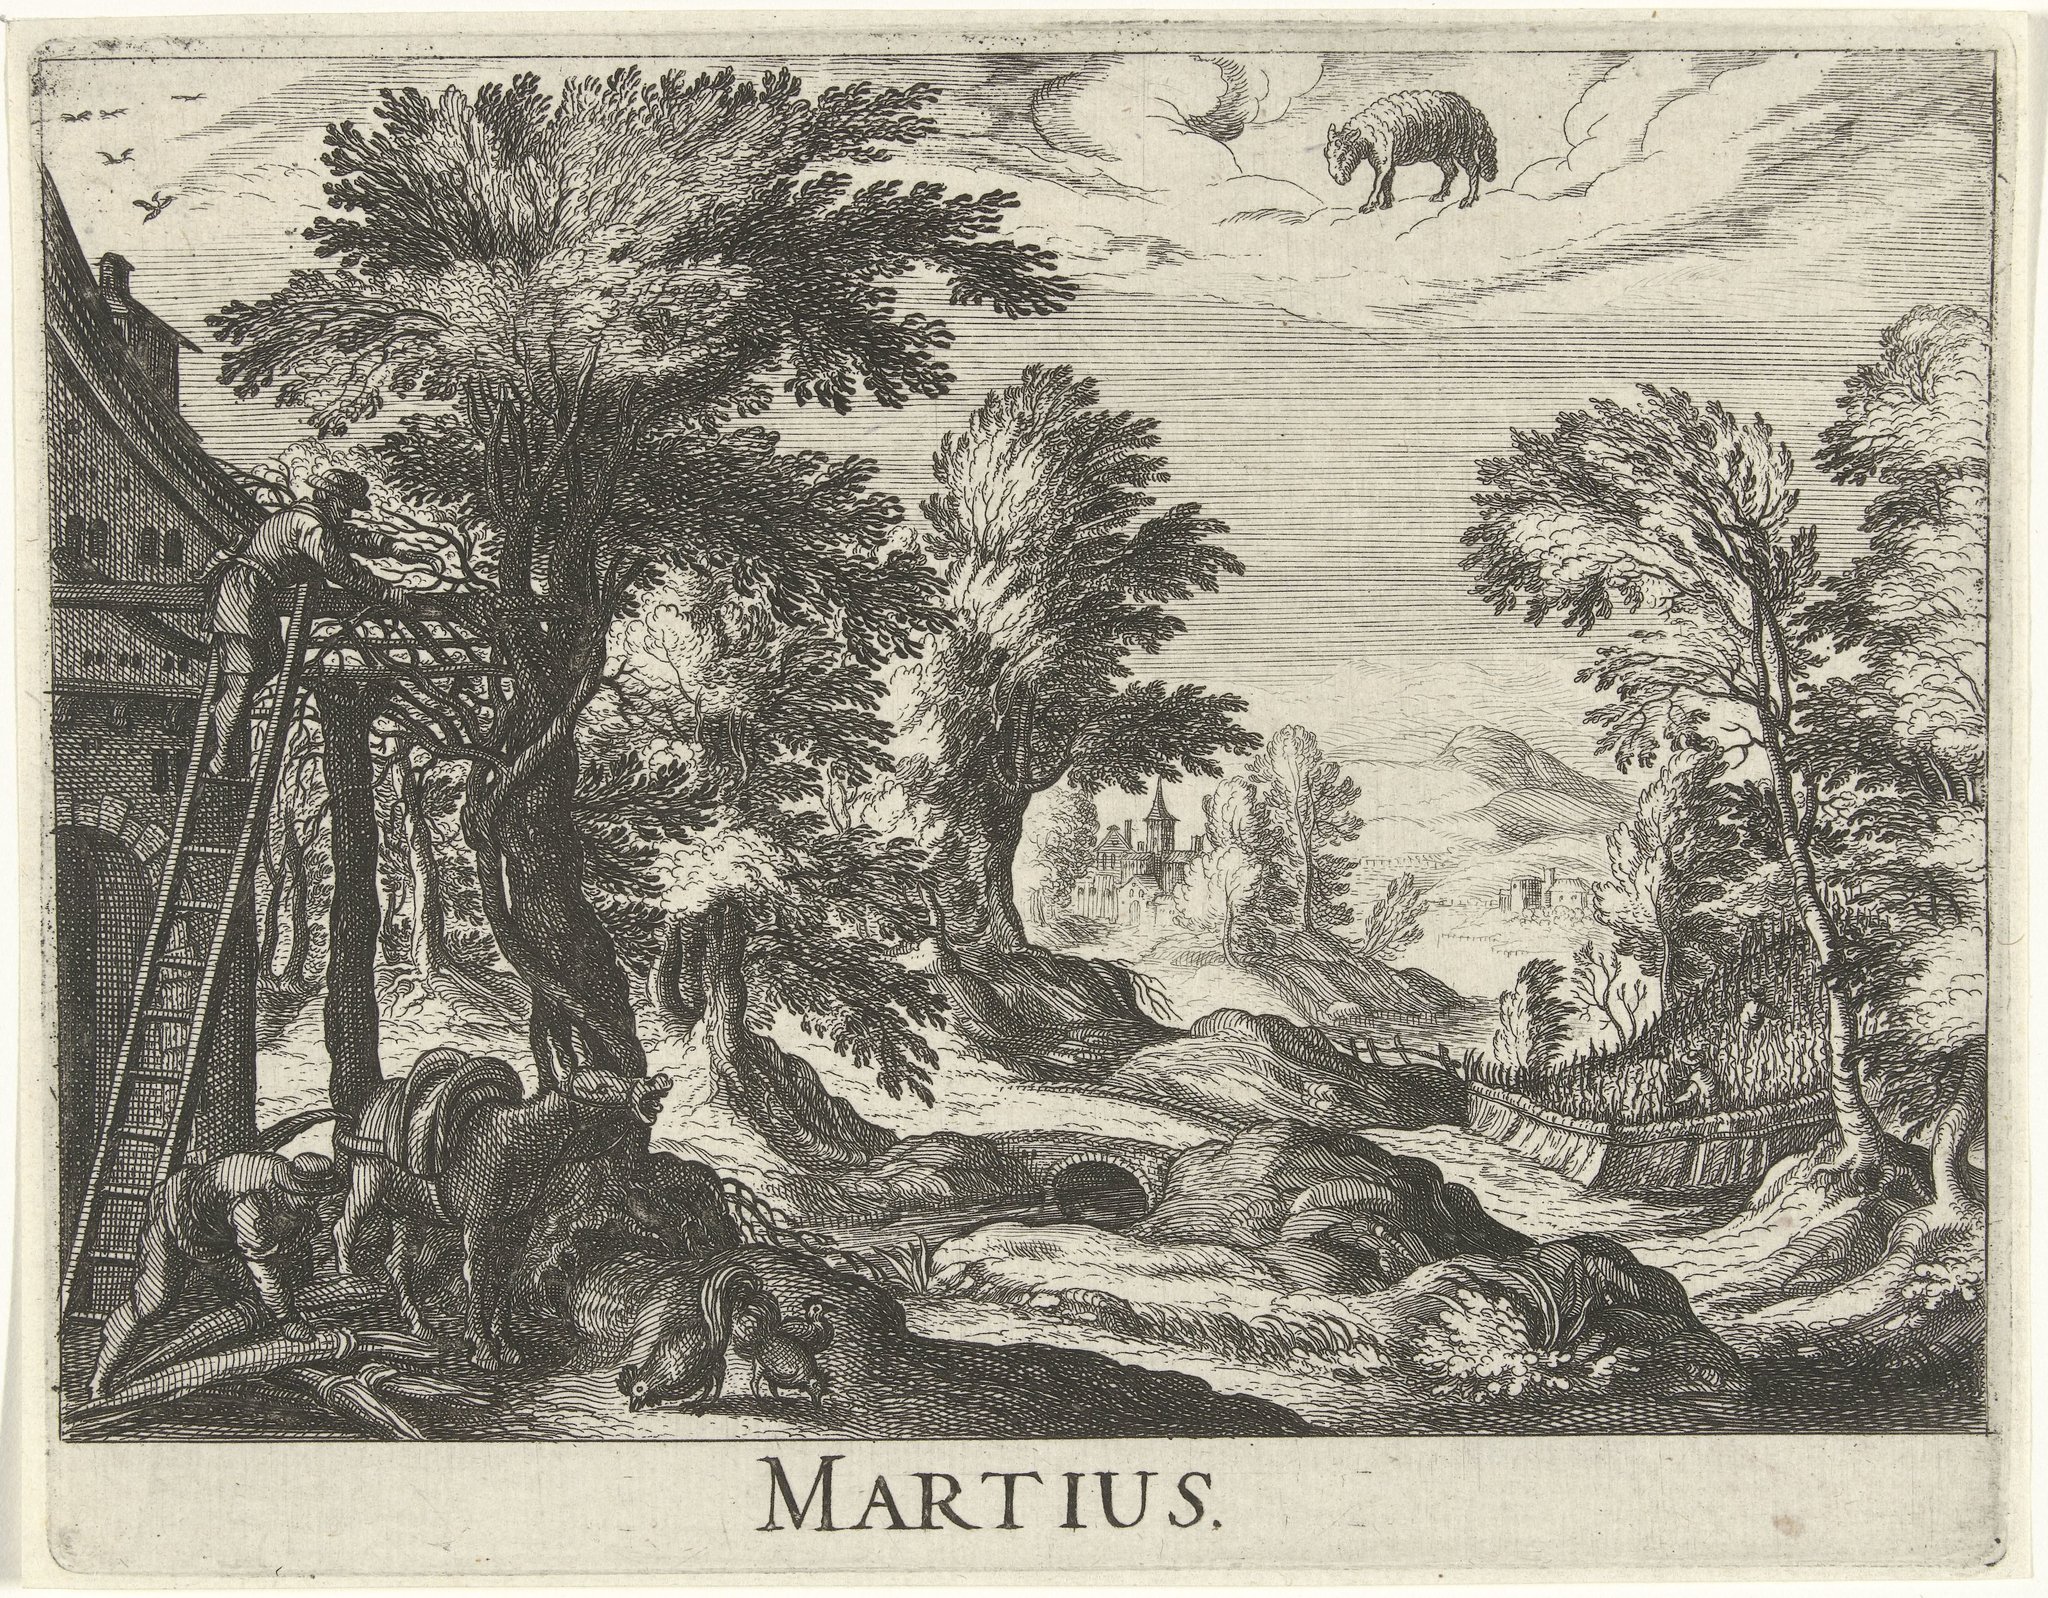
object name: print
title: Maart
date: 1611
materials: paper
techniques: etching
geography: northern netherlands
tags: landscape symbolizing february (+ with signs or personifications of the planets)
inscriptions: collector's mark: Lugt 240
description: De maand maart wordt voorgesteld door een heuvellandschap met enkele figuren voor een woning. Op de achtergrond is in de lucht het sterrenbeeld Ram weergegeven.